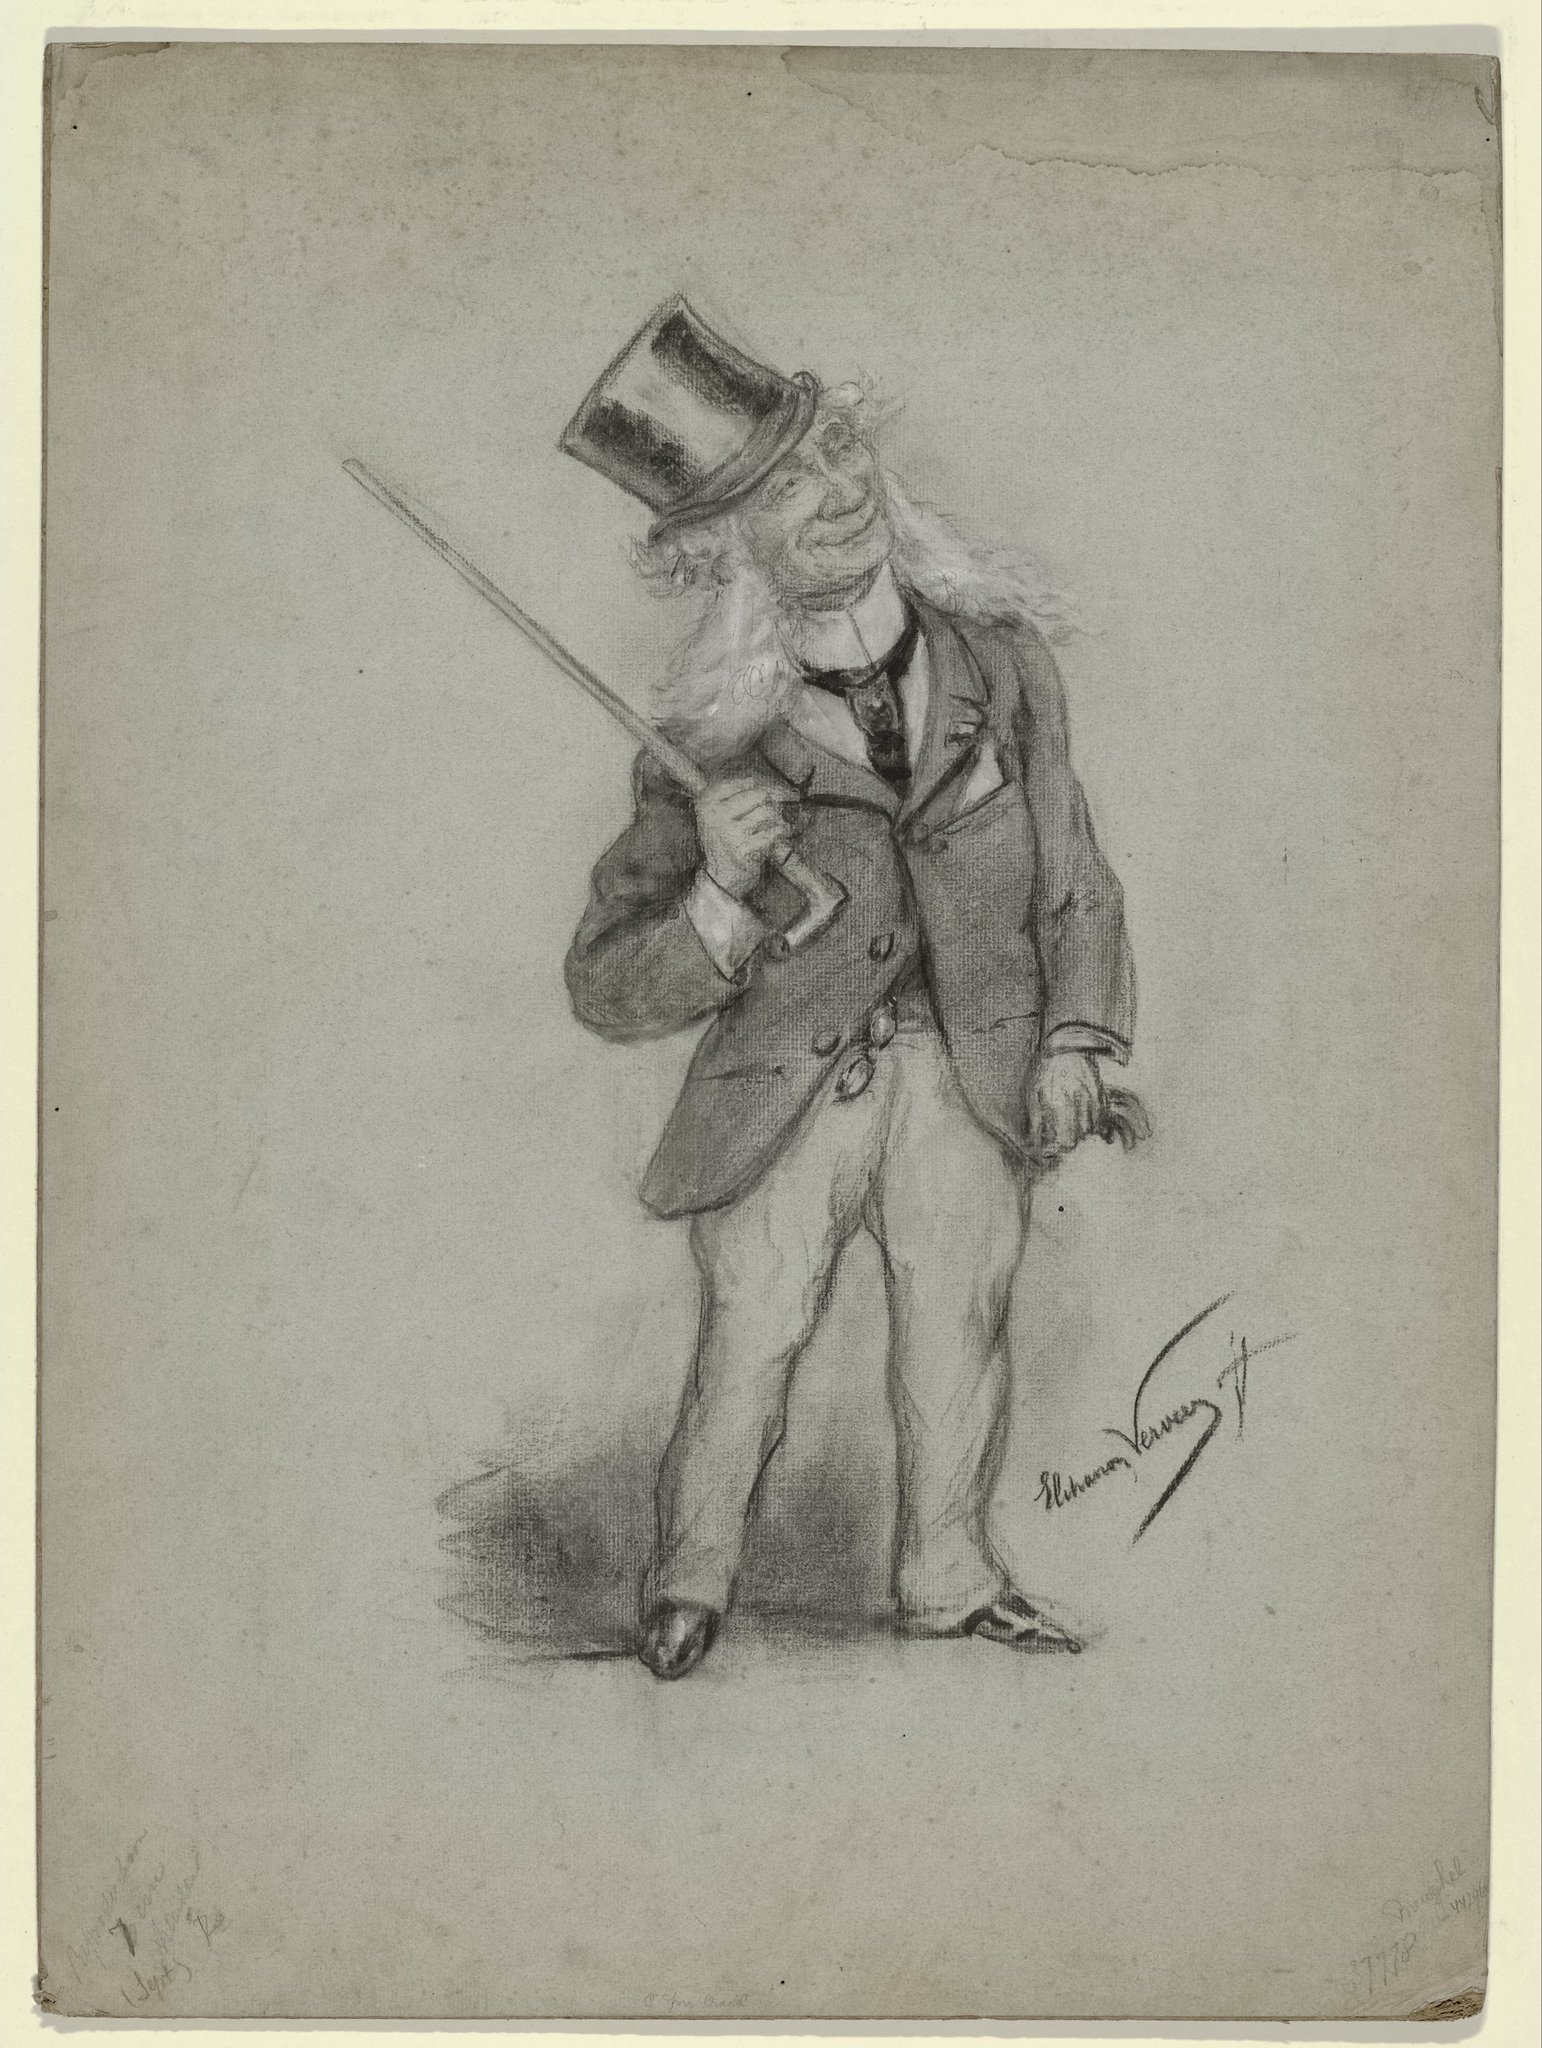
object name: drawing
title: Karikatuurportret van de kunstschilder David Joseph Bles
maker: elchanon verveer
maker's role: draughtsman, print maker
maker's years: 1826-1900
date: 1836-1900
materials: chalk, charcoal, paper, pencil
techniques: brush, stumping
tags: the hague, painter, print maker, draughtsman, david bles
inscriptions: signature: ‘Elchanon Verveer ft’, inscription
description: Karikatuurportret van de kunstschilder David Joseph Bles (1821-1899).